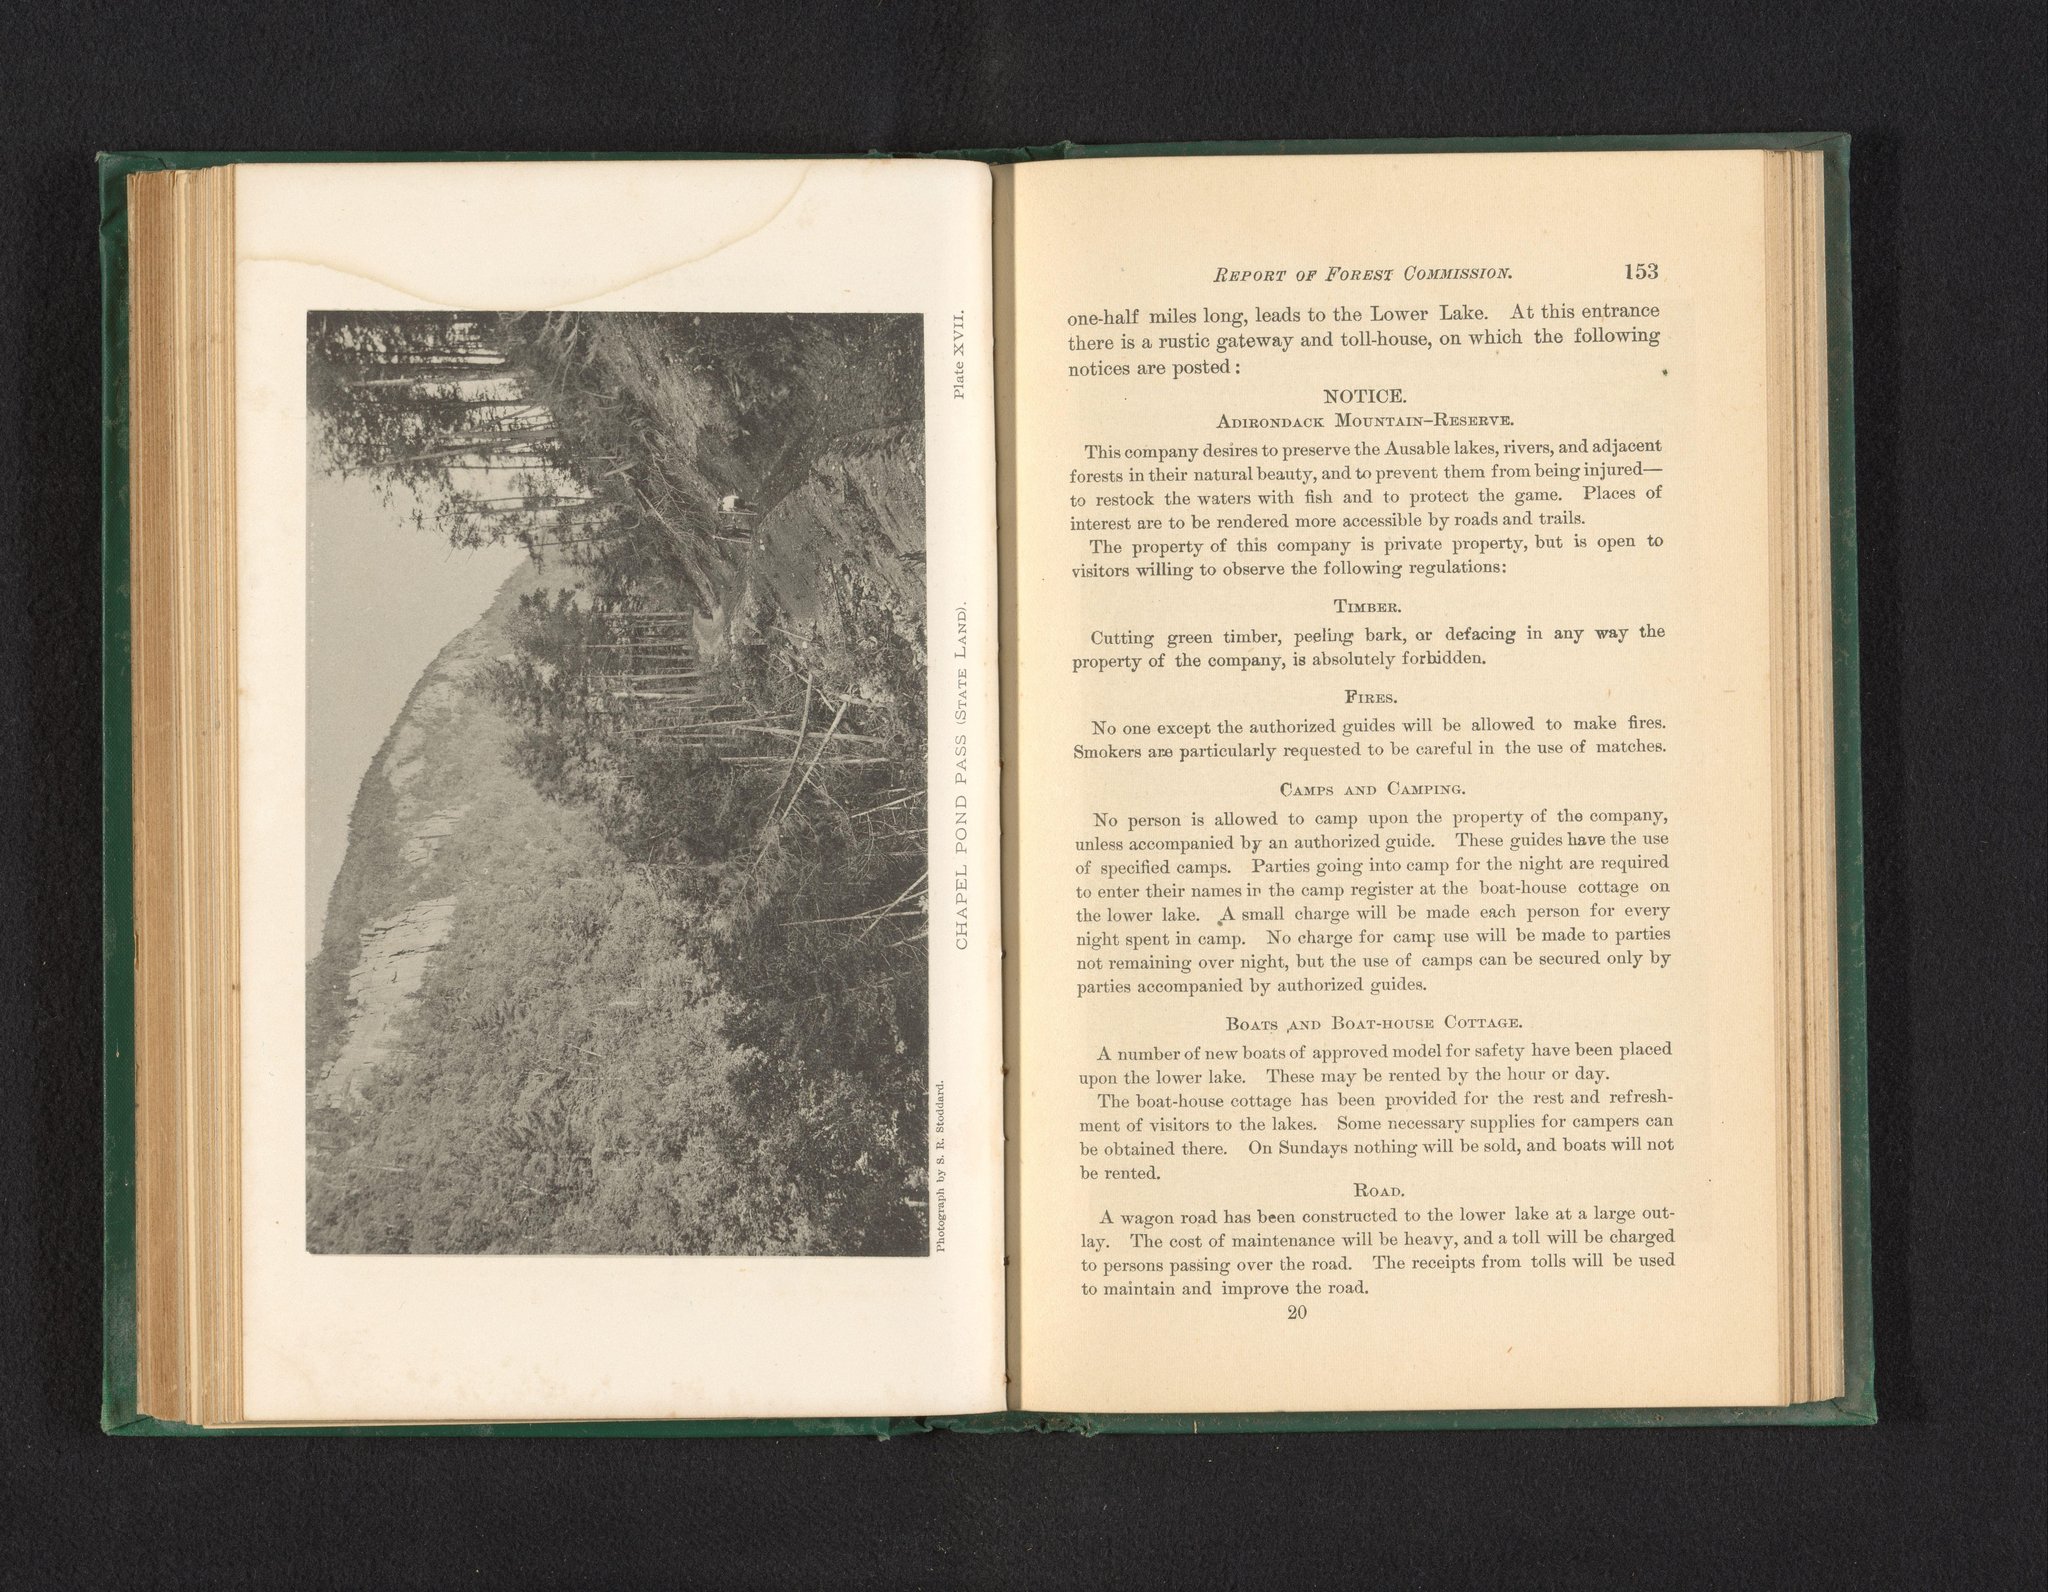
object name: page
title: Chapel Pond Pass (State land)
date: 1891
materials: paper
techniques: photograph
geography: new york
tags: mountains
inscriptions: number: ‘Plate XVII.’